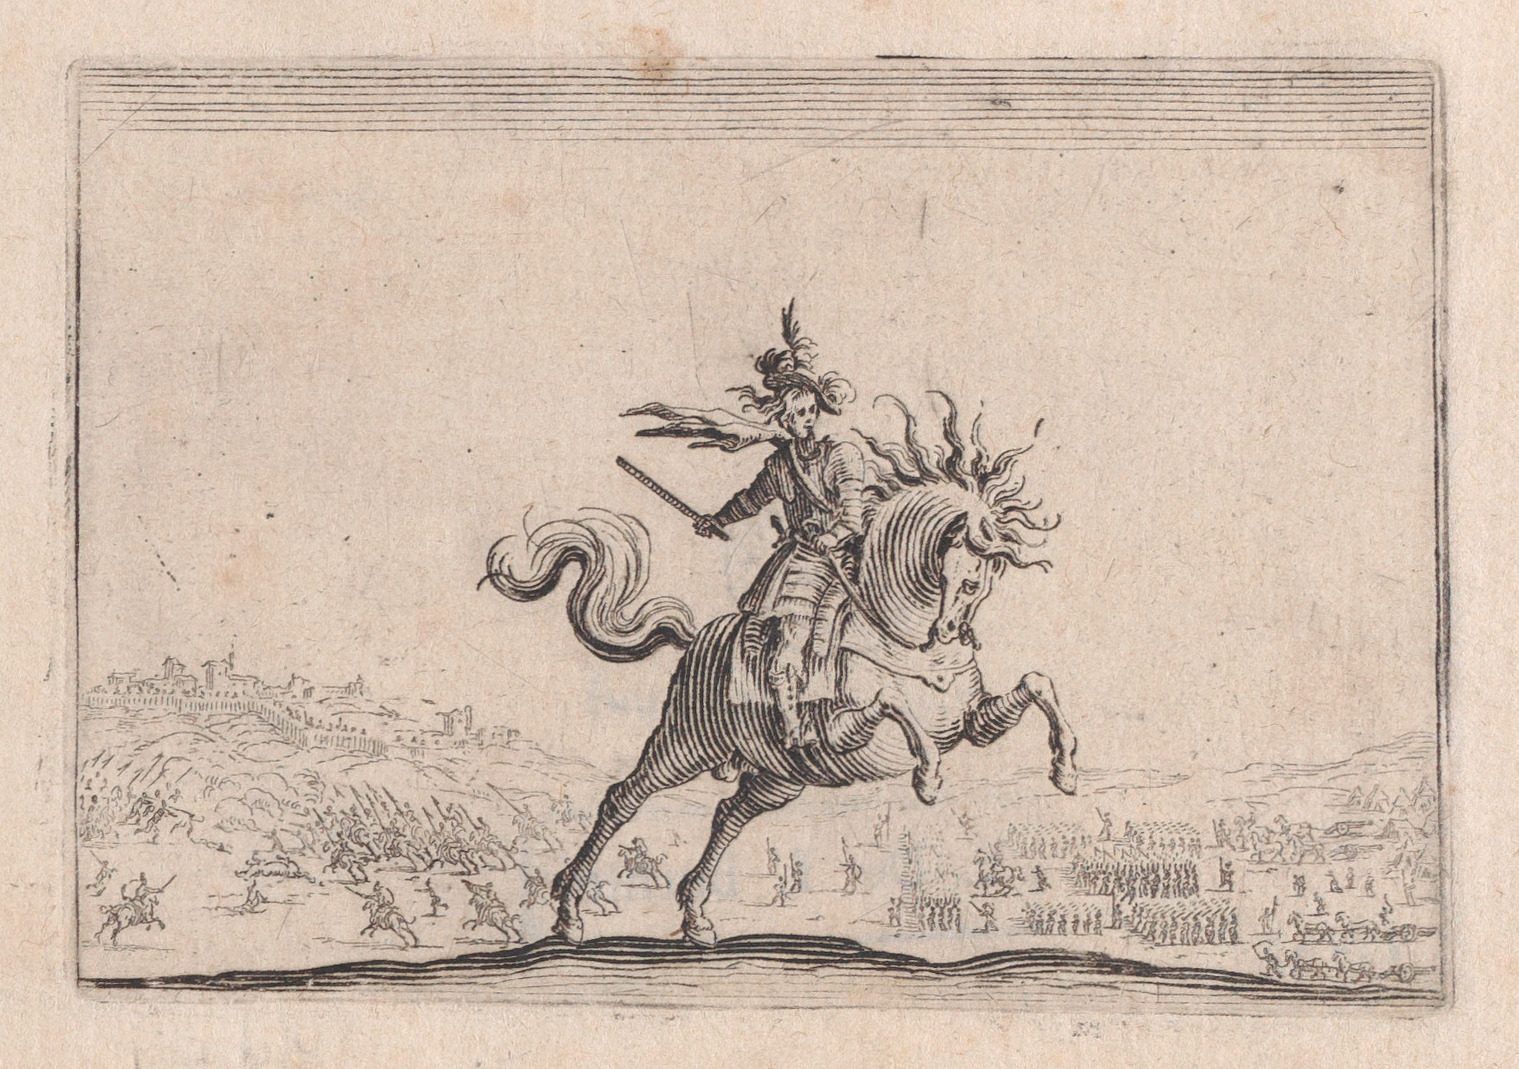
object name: print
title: Le Commandant a Cheval (The Commander on Horseback), from "Les Caprices" Series B, The Nancy Set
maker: jacques callot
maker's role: artist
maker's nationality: french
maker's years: 1592-1635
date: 1617-1620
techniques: etching